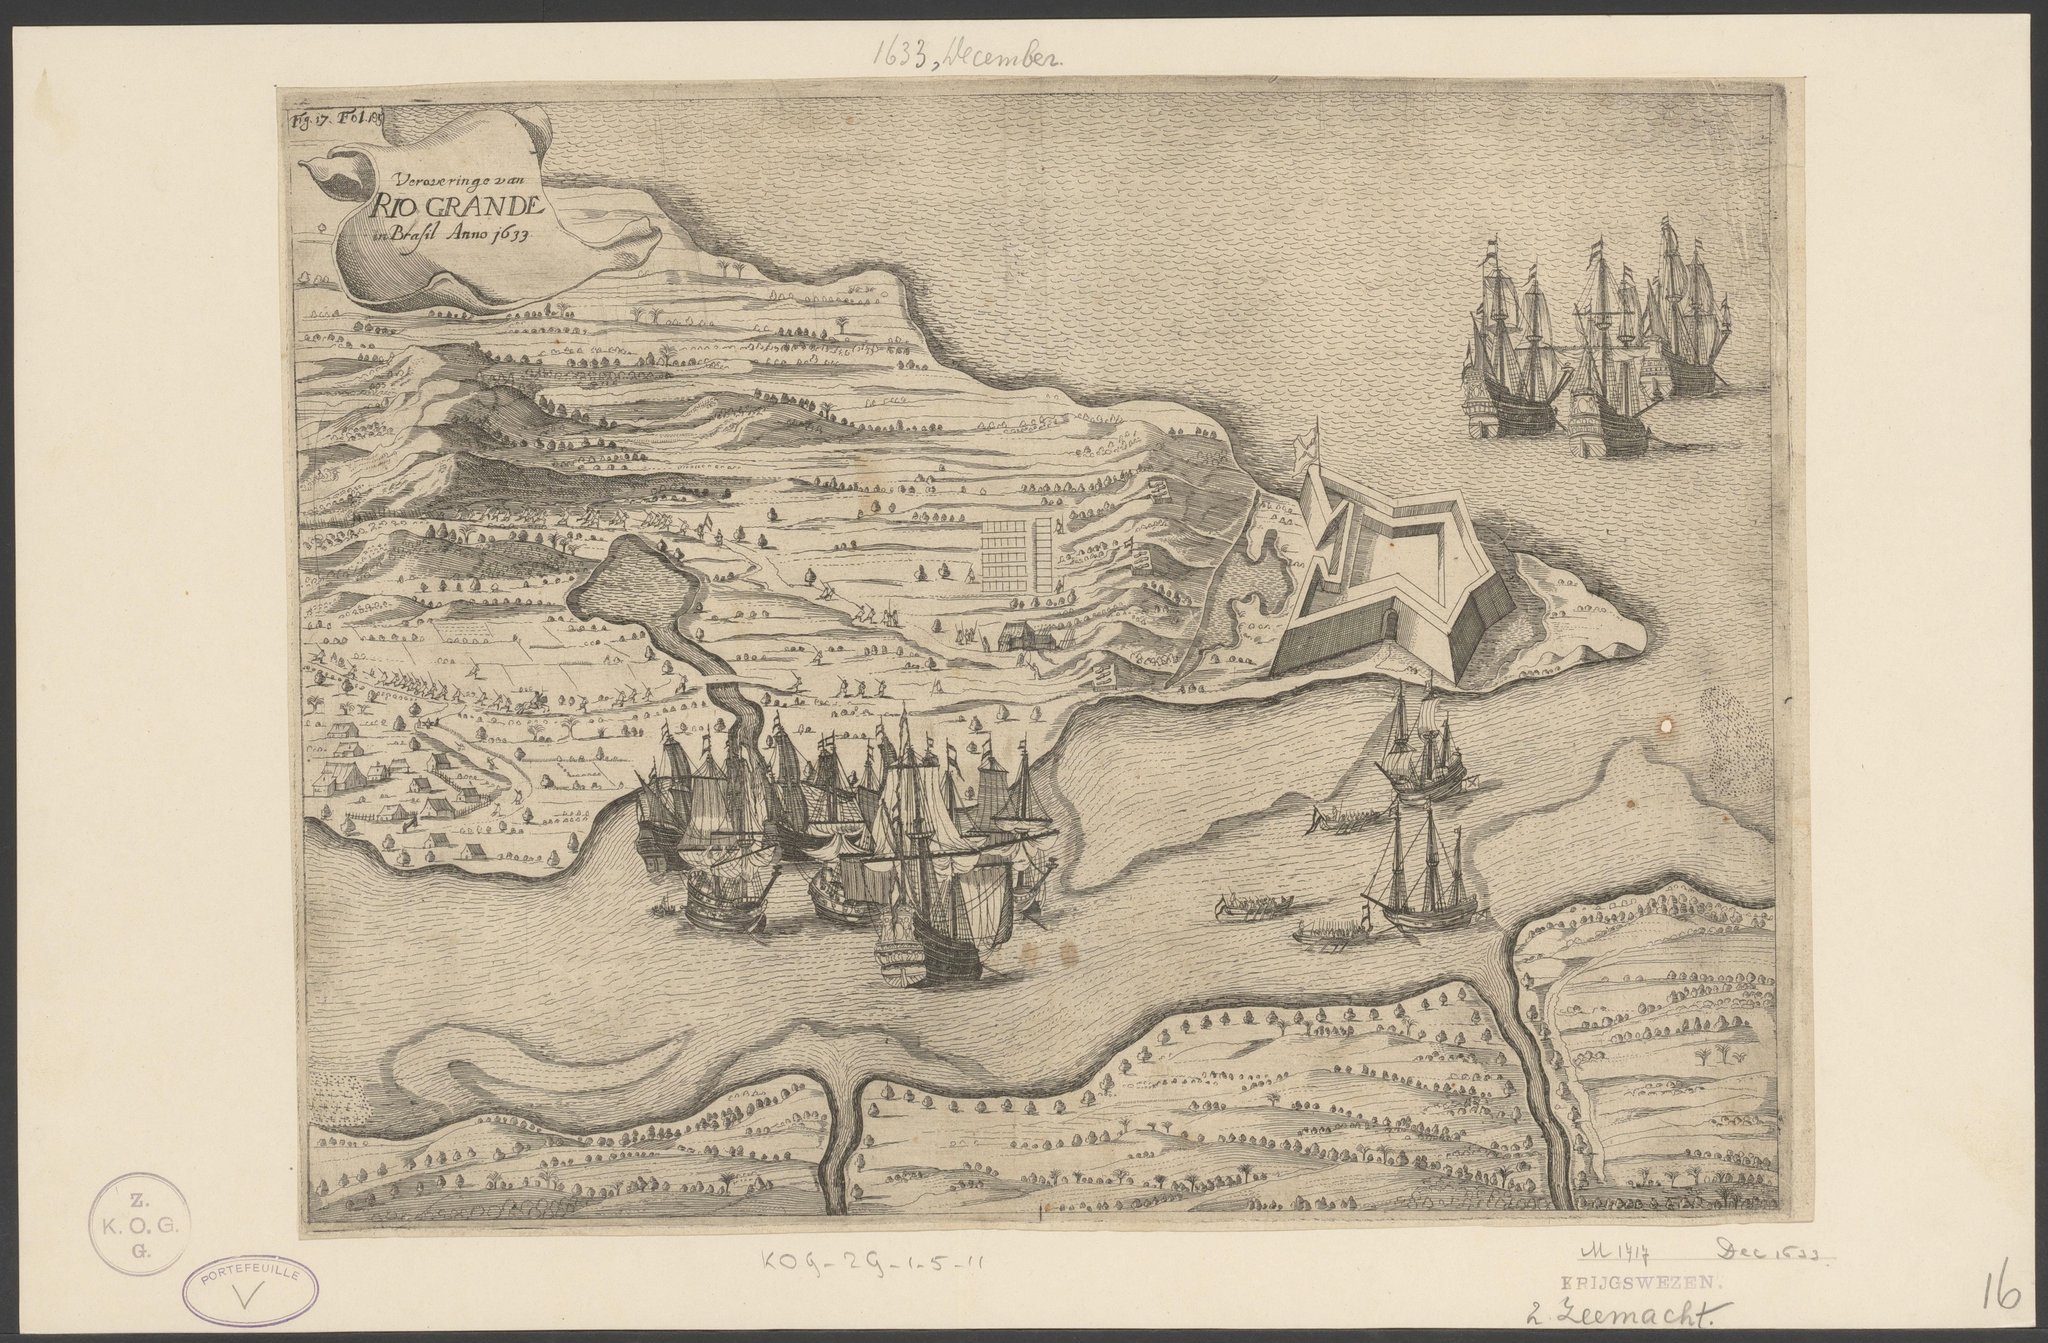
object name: print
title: Verovering van Rio Grande in Brazilië, 1633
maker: Anonymous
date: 1651-1699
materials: paper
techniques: etching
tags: sailing-ship, sailing-boat, maps of separate countries or regions, capture of city (after the siege), brasil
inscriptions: collector's mark: Lugt 1641, stamp, stamp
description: Verovering van Rio Grande in Brazilië, december 1633. Plan van de Braziliaanse kust met een kasteel aan de monding van de rivier Rio Grande. De naam van het kasteel Tres Reyes werd na verovering veranderd in Keulen. Voor de kust en in de rivier liggen Nederlandse schepen voor anker. Linksboven genummerd: Fig. 17 Fol. 185. Onderwerpsrubrieken binnen de Atlas Zeden en Gewoonten: Krijgswezen, Zeemacht.